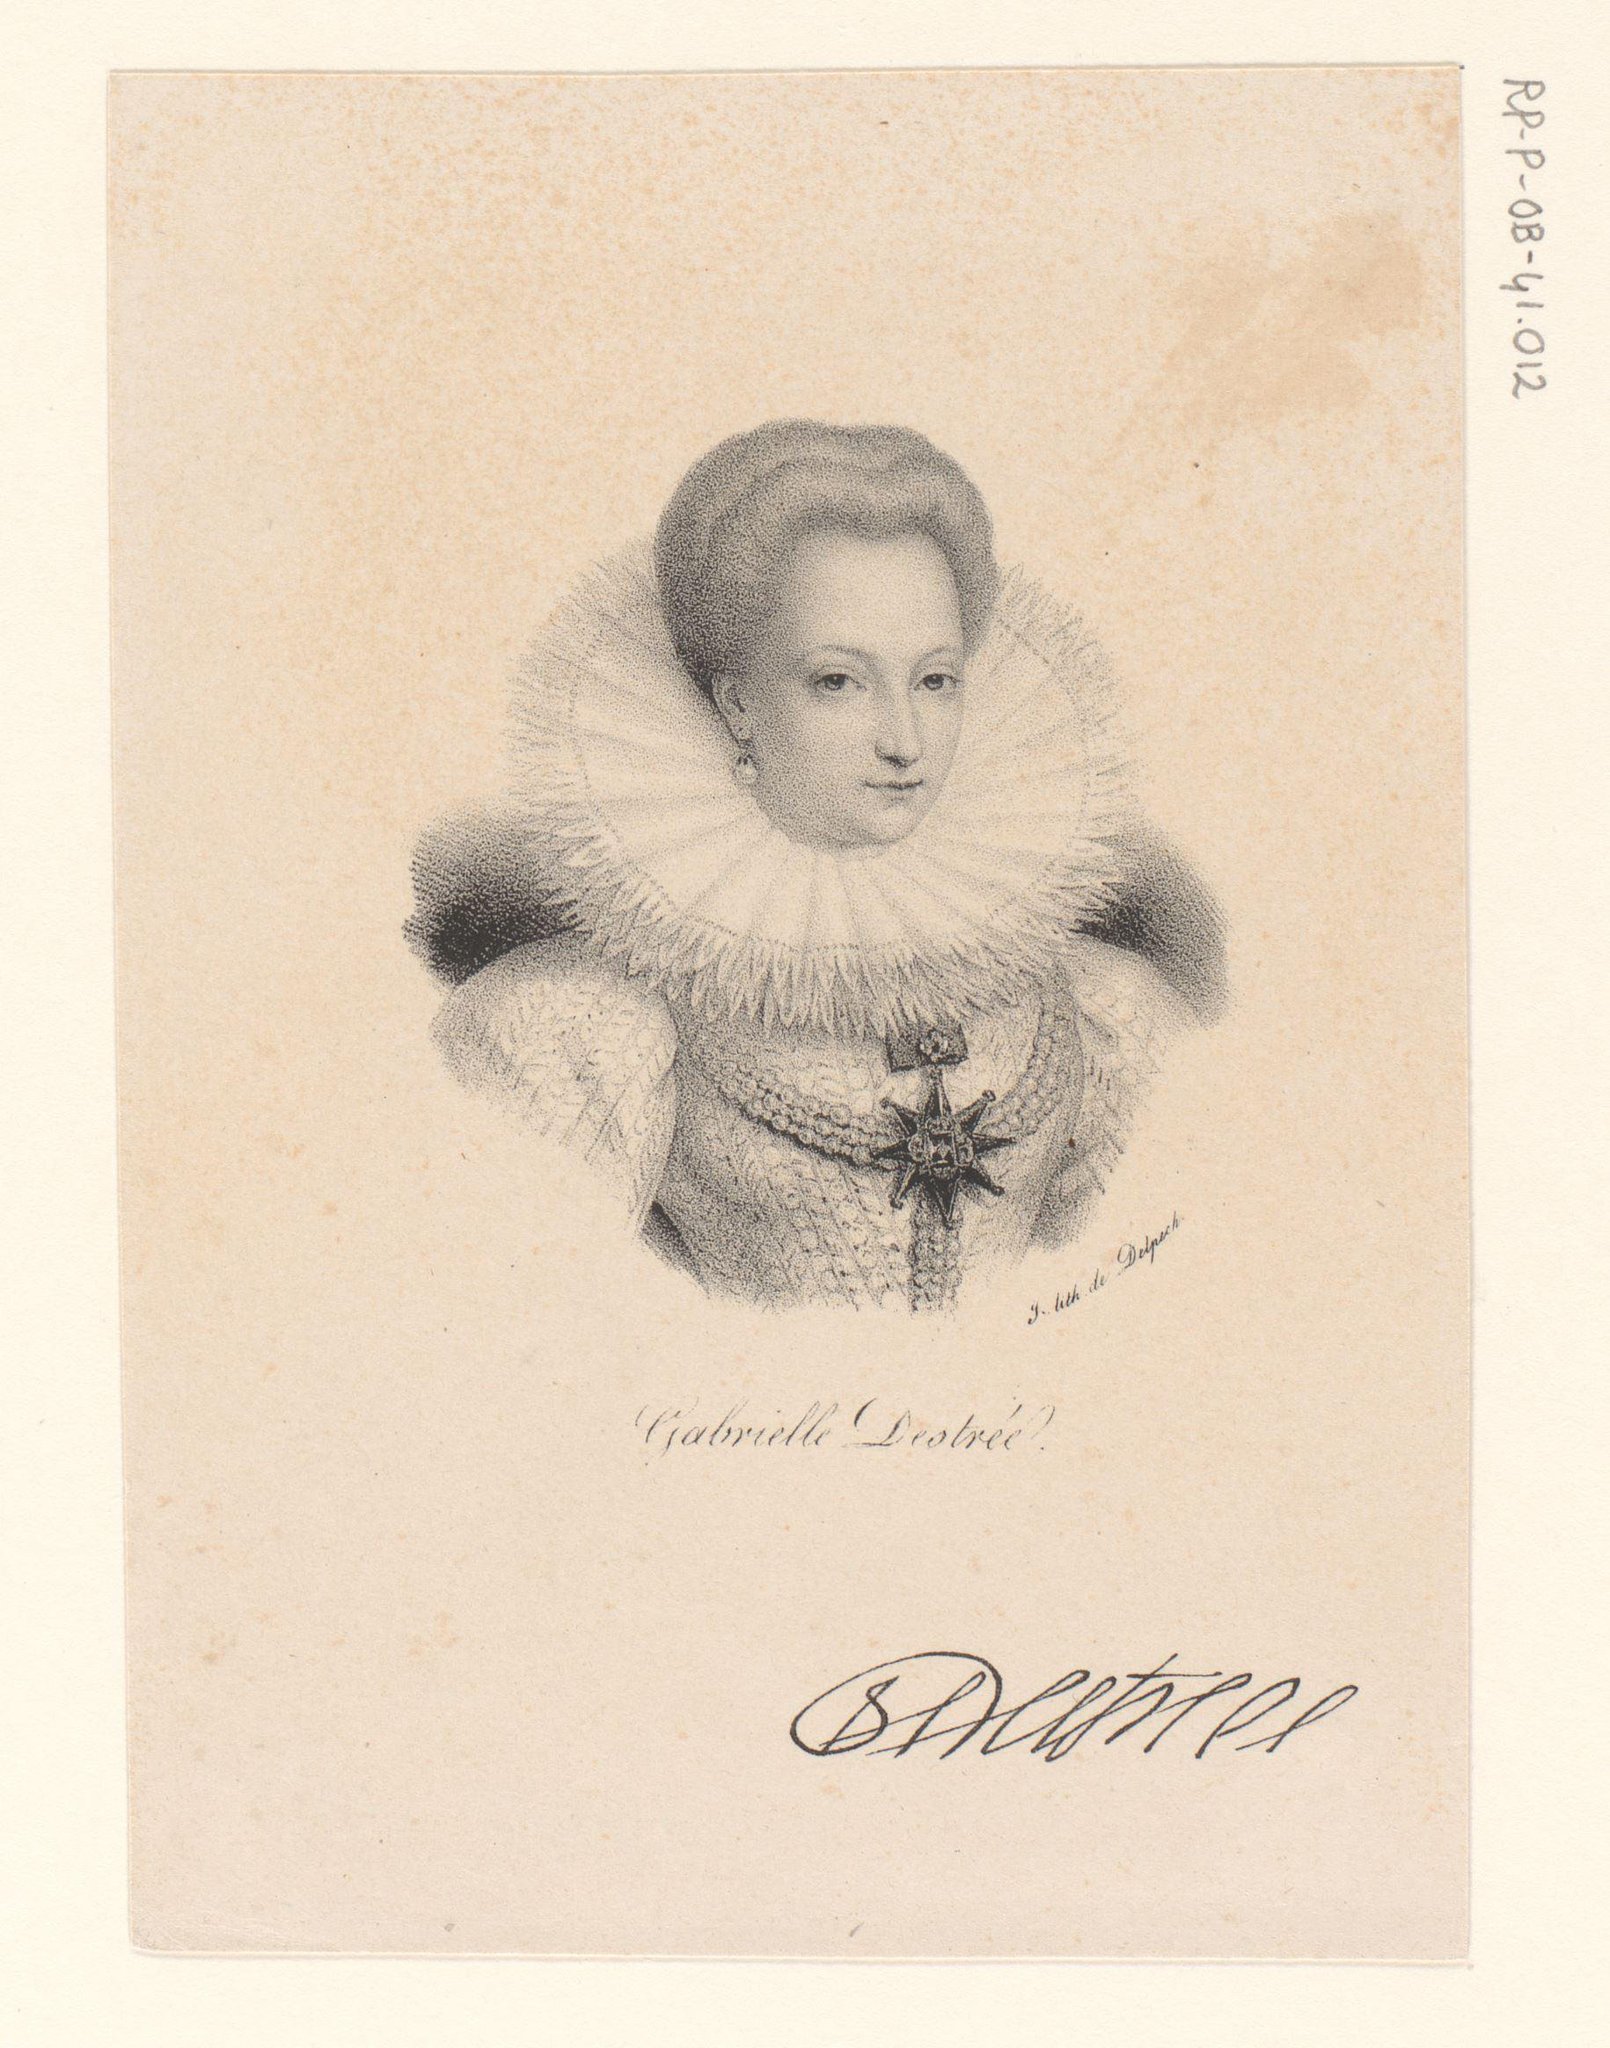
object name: print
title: Gabrielle Destrée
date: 1818-1842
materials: paper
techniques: lithograph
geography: paris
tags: historical persons